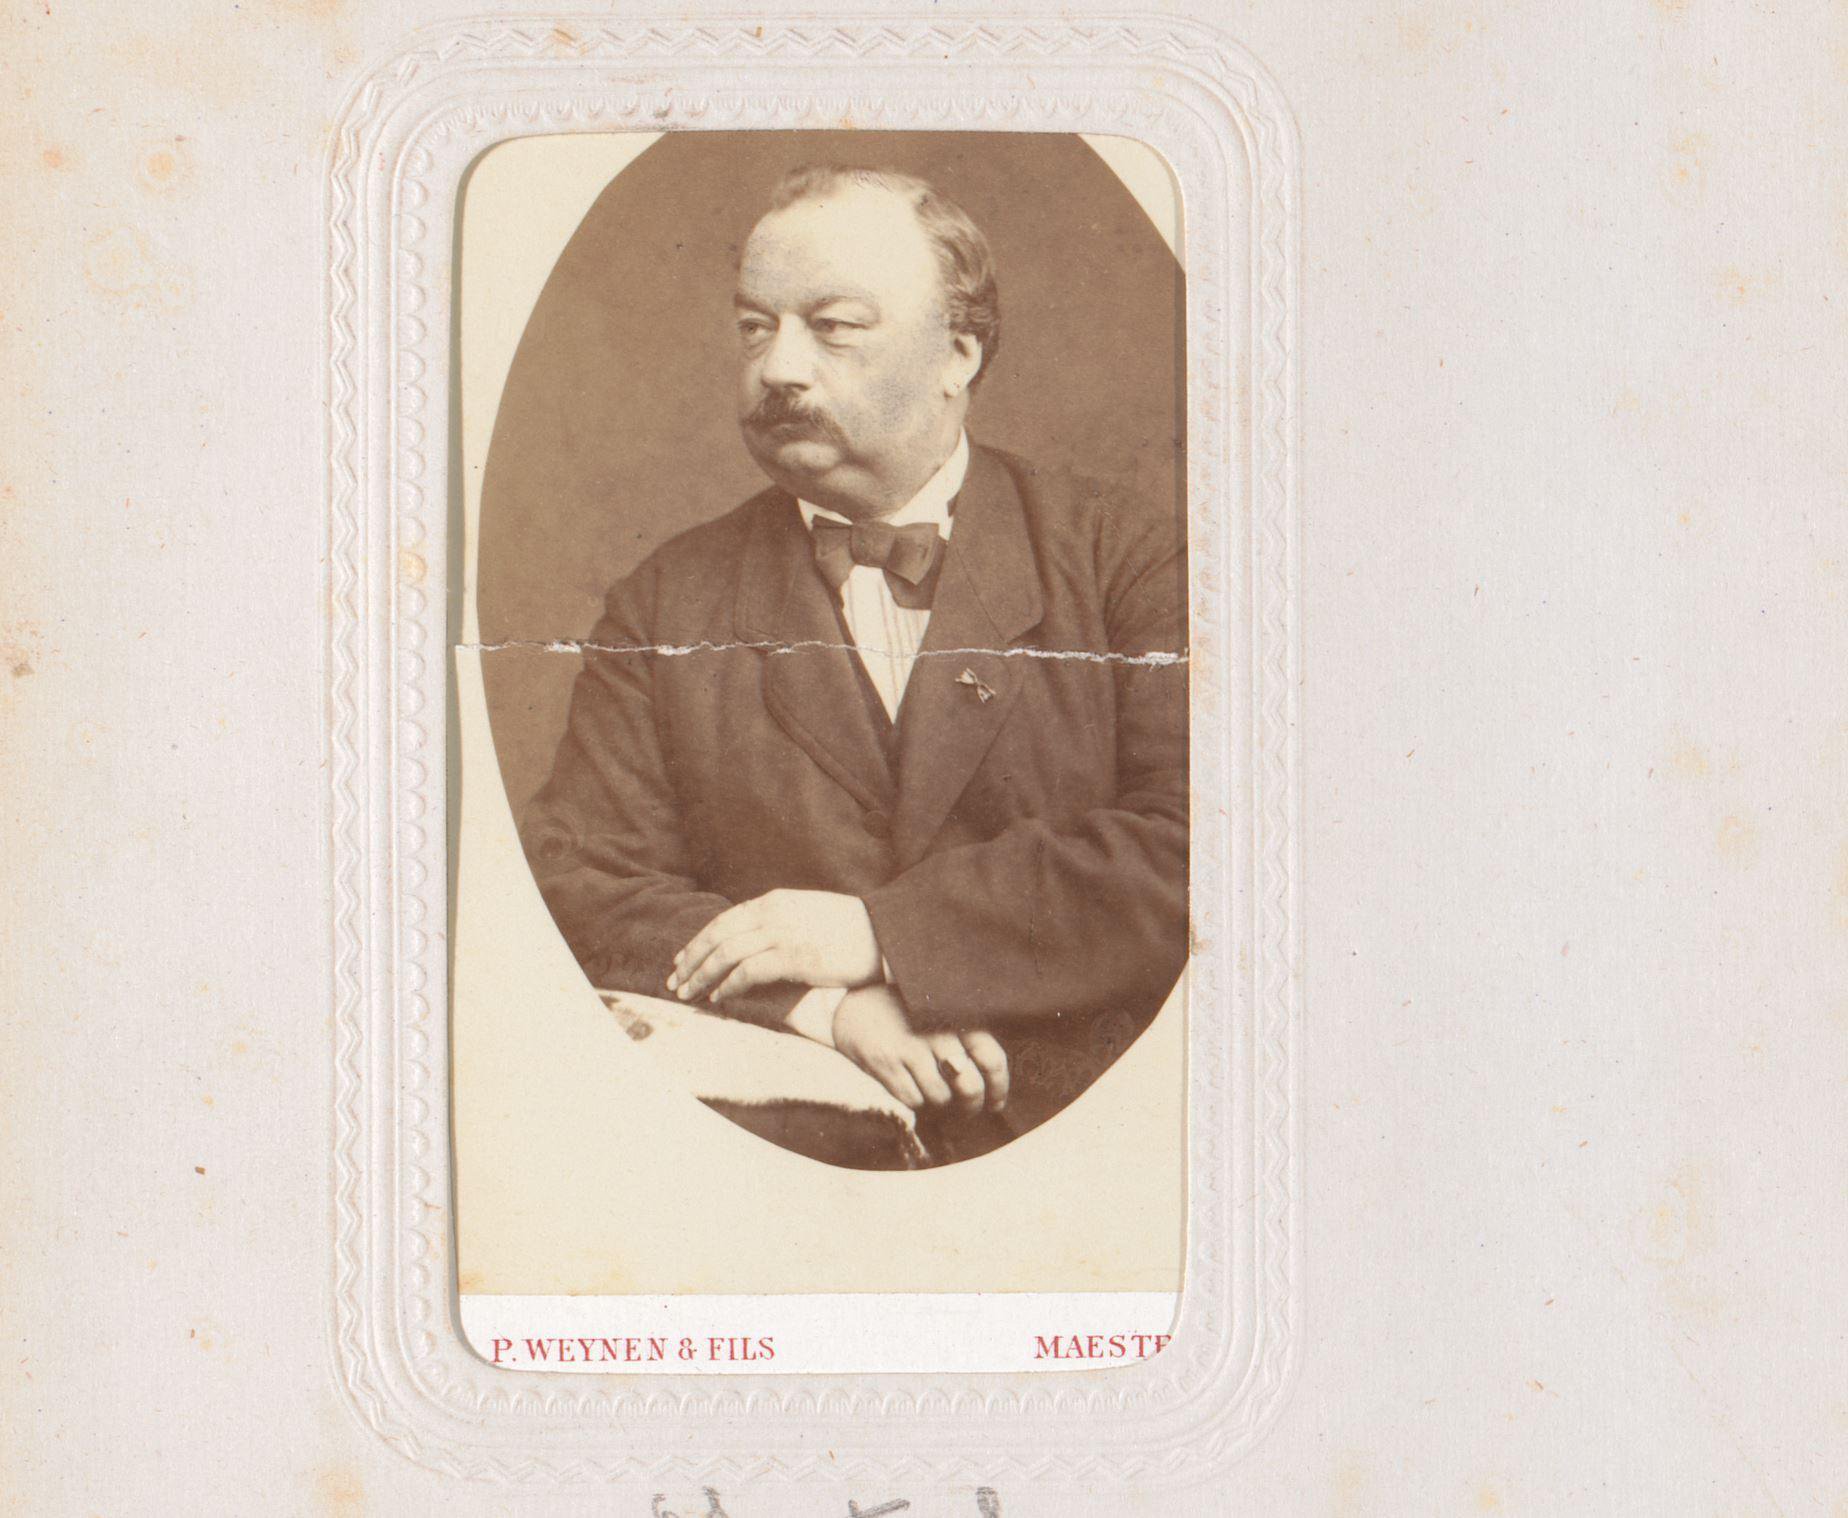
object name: carte de visite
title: Portret van een zittende man, aangeduid als Van Opstal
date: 1876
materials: cardboard, photographic support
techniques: albumen print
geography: maastricht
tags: sitting figure, historical persons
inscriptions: inscription: ‘No.../ Photographie/ P. Weynen & fils/ Rue du Casque 1776./ Maestricht/ Les clichés sont conservés.’, annotation: ‘3 Aug 1876/ [..] v Opstal’, name: ‘v. Opstal’